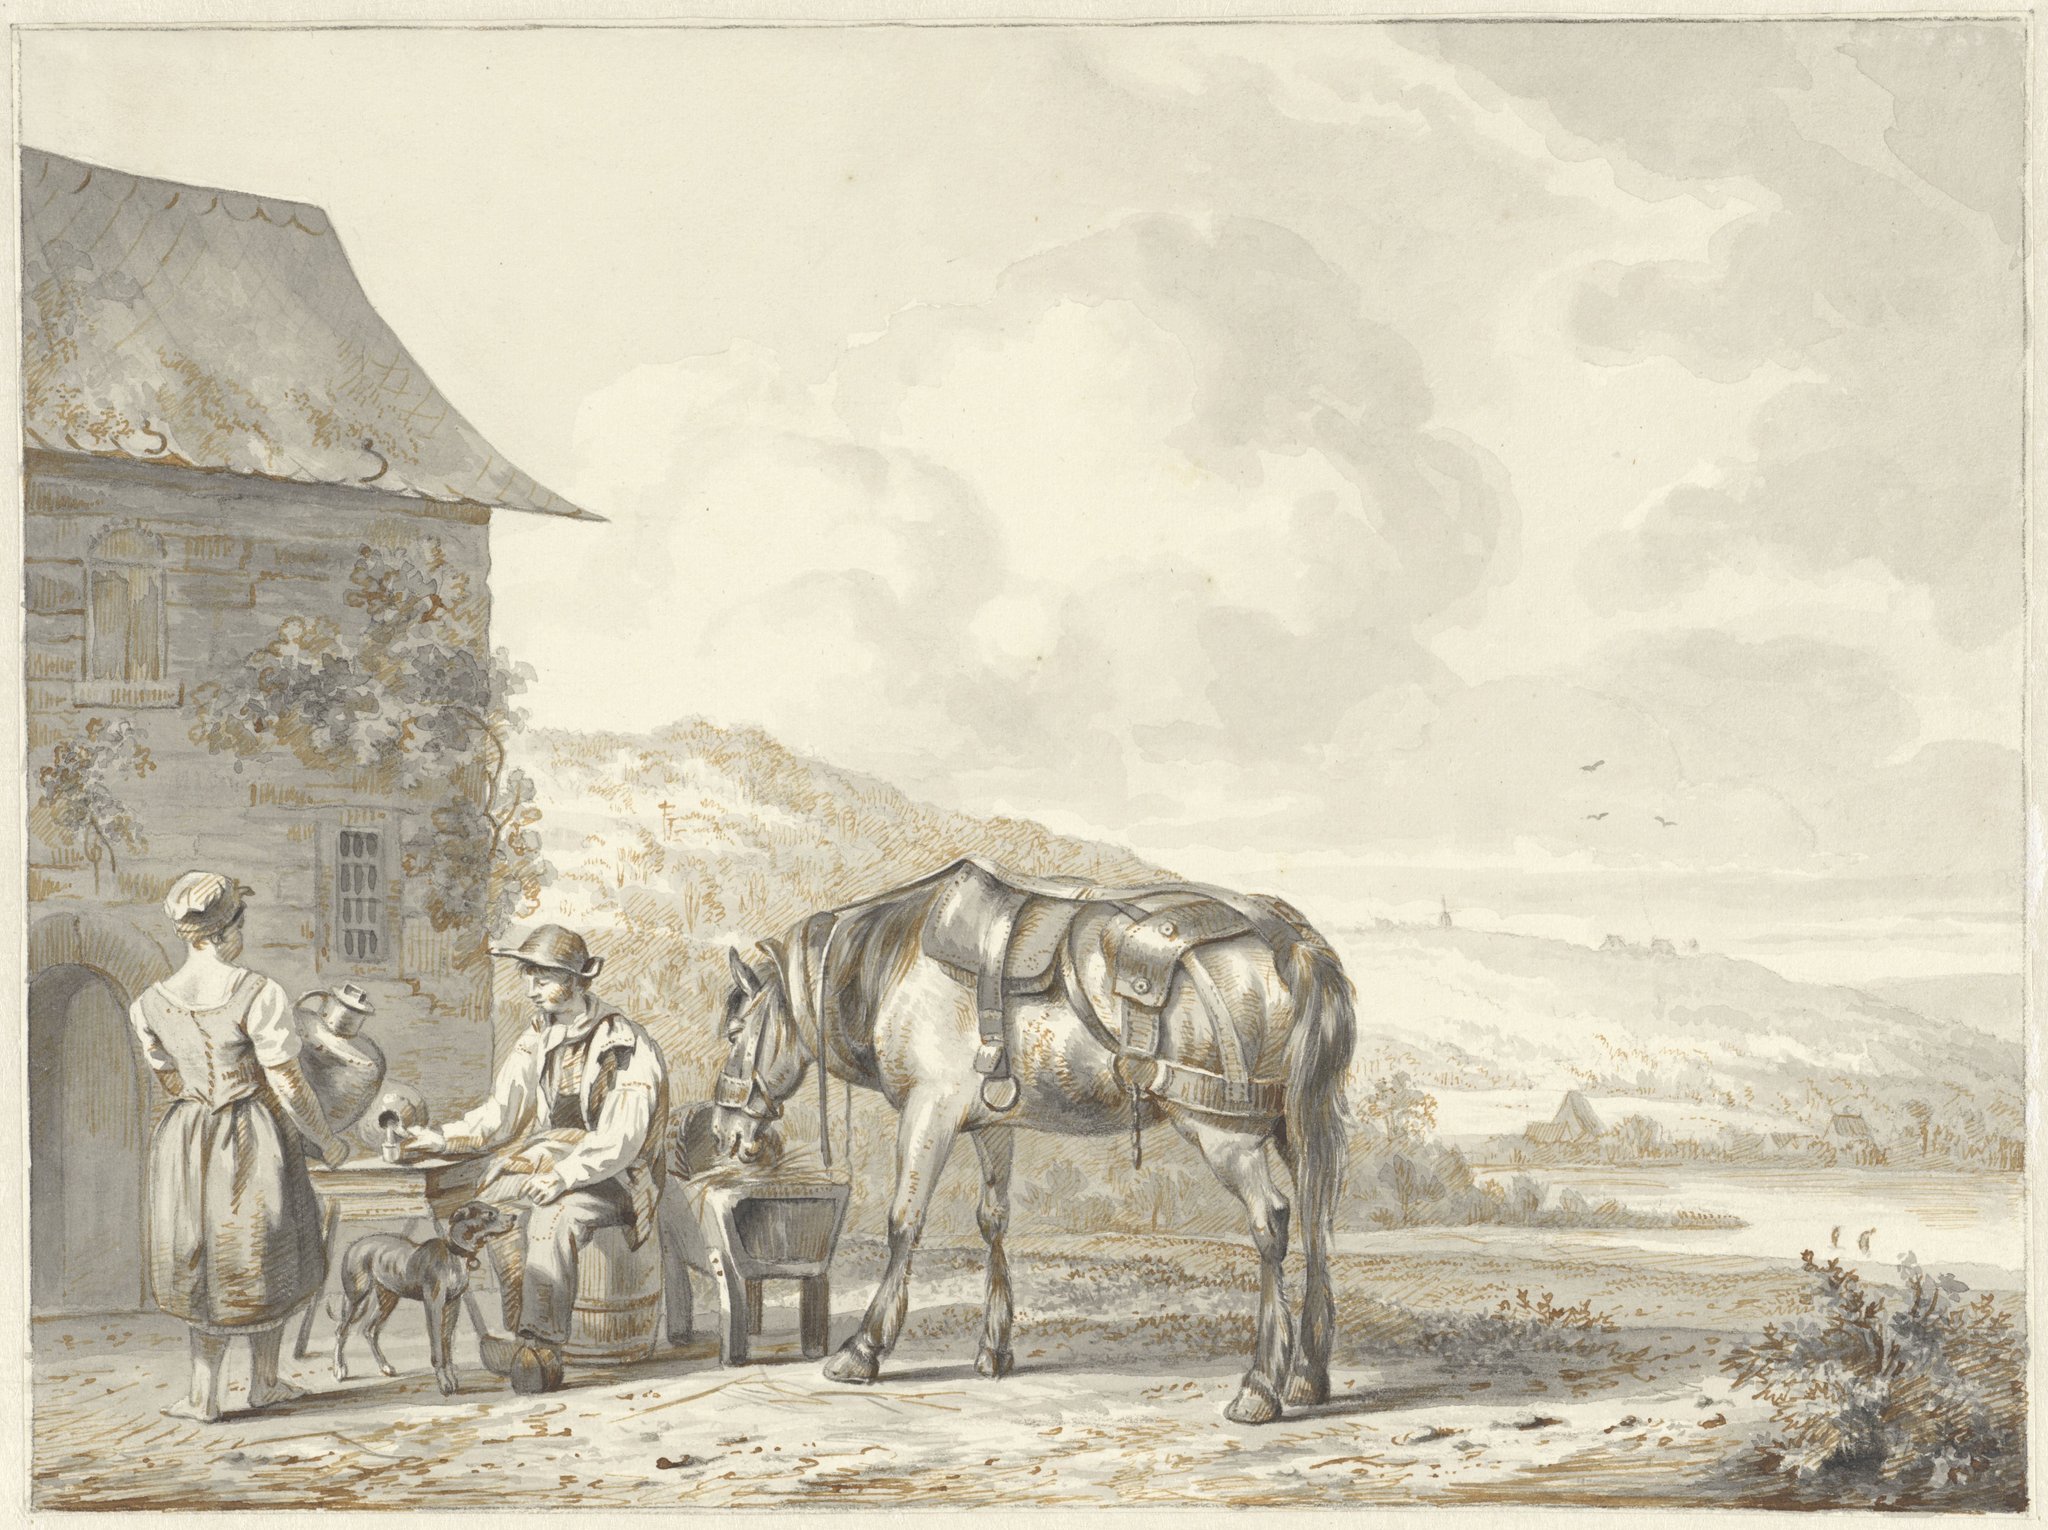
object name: drawing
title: Man met paard, rustend bij een herberg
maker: pieter frederik van os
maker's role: draughtsman, painter, print maker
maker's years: 1808-1892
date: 1839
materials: ink, paper, pencil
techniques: brush, pen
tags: (traveller) resting in the open air, horse